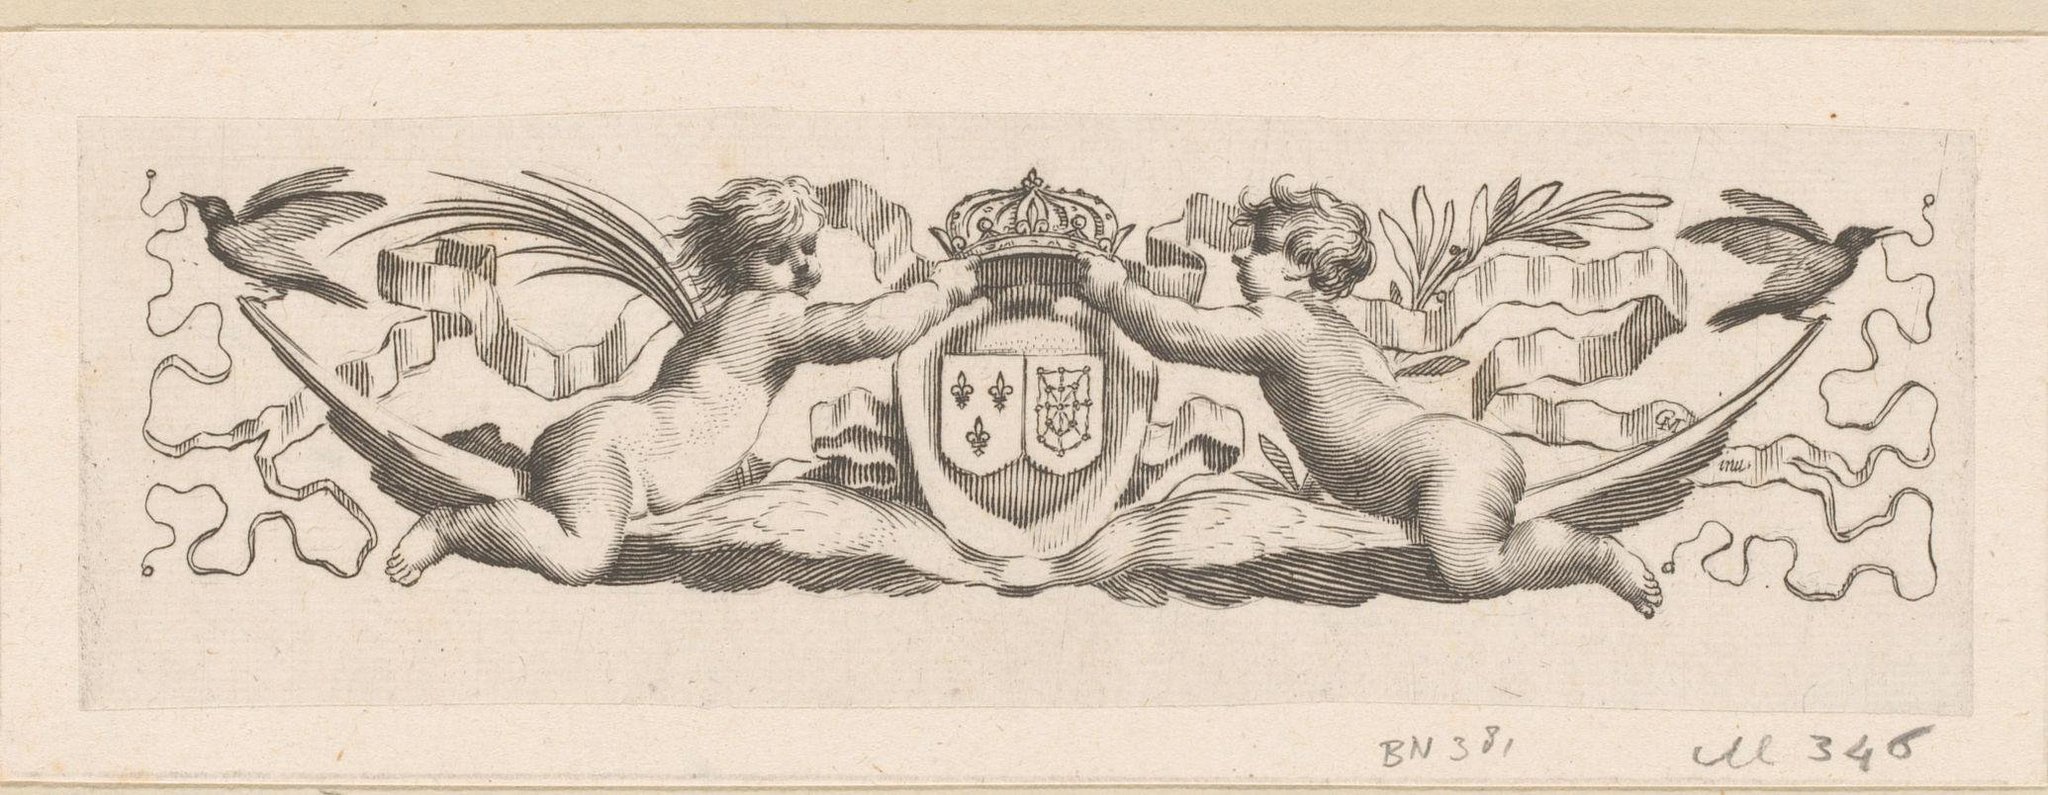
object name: print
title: Putti die de wapens van Frankrijk en Navarra bekronen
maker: claude mellan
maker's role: draughtsman, print maker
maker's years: 1598-1688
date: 1639-1643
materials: paper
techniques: engraving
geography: france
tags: cupids: 'amores', 'amoretti', 'putti', armorial bearing, heraldry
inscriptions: collector's mark: Lugt 240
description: Tussen 1639-1643 werkte Mellan samen met de Imprimerie Royale (IFF 17e siècle, p. 21-22). Hij vervaardigde verschillende vignetten, letters, culs-de-lampe en decoratieve banden (IFF 17e siècle, p. 215-220). O.a. gebruikt voor de publicatie: Vergilius Maro, Publius. Publii Virgilii Maronis Opera. Parijs: Imprimerie Royale, 1641. Zie IFF 17e siècle, p. 215, nr. 381.